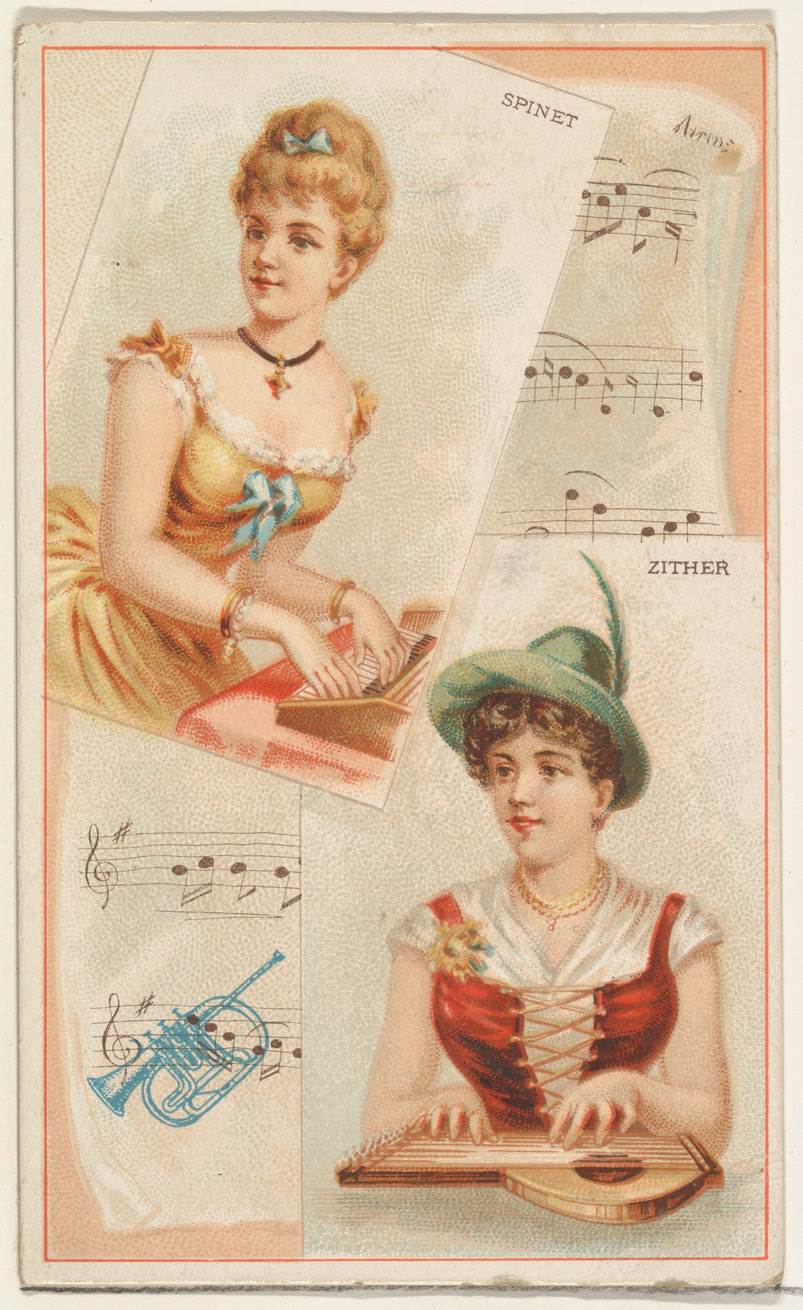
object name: print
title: Spinet and Zither, from the Musical Instruments series (N121) issued by Duke Sons & Co. to promote Honest Long Cut Tobacco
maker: w. duke, sons & co.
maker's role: publisher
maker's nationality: american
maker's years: 1870-1920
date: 1888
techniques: color lithograph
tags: musical instruments,women